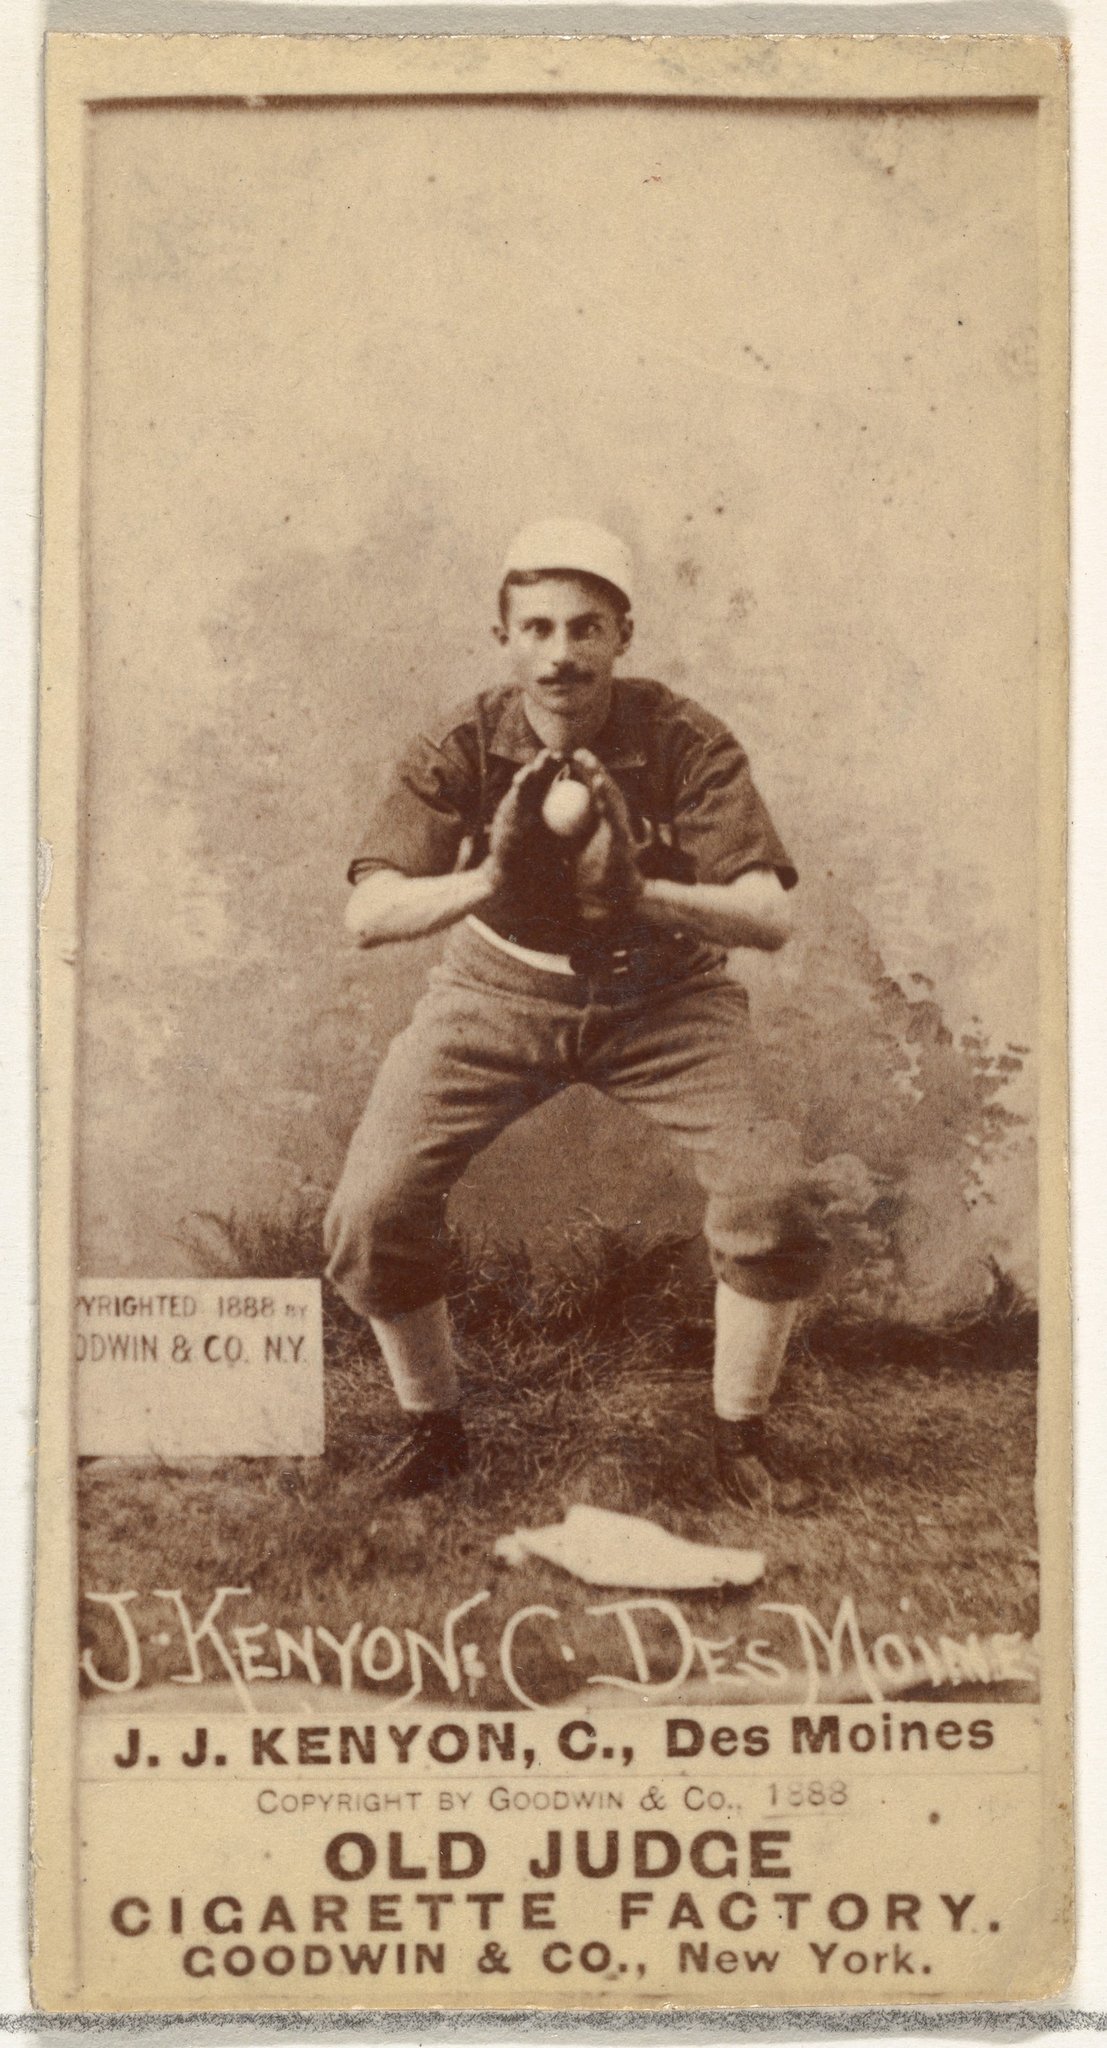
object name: baseball card, photograph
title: P. Jacob "Jack" Kenyon, Catcher, Des Moines Prohibitionists, from the Old Judge series (N172) for Old Judge Cigarettes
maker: goodwin & company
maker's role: publisher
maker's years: 1850-1950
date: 1888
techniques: albumen silver print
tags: men,portraits,baseball,athletes